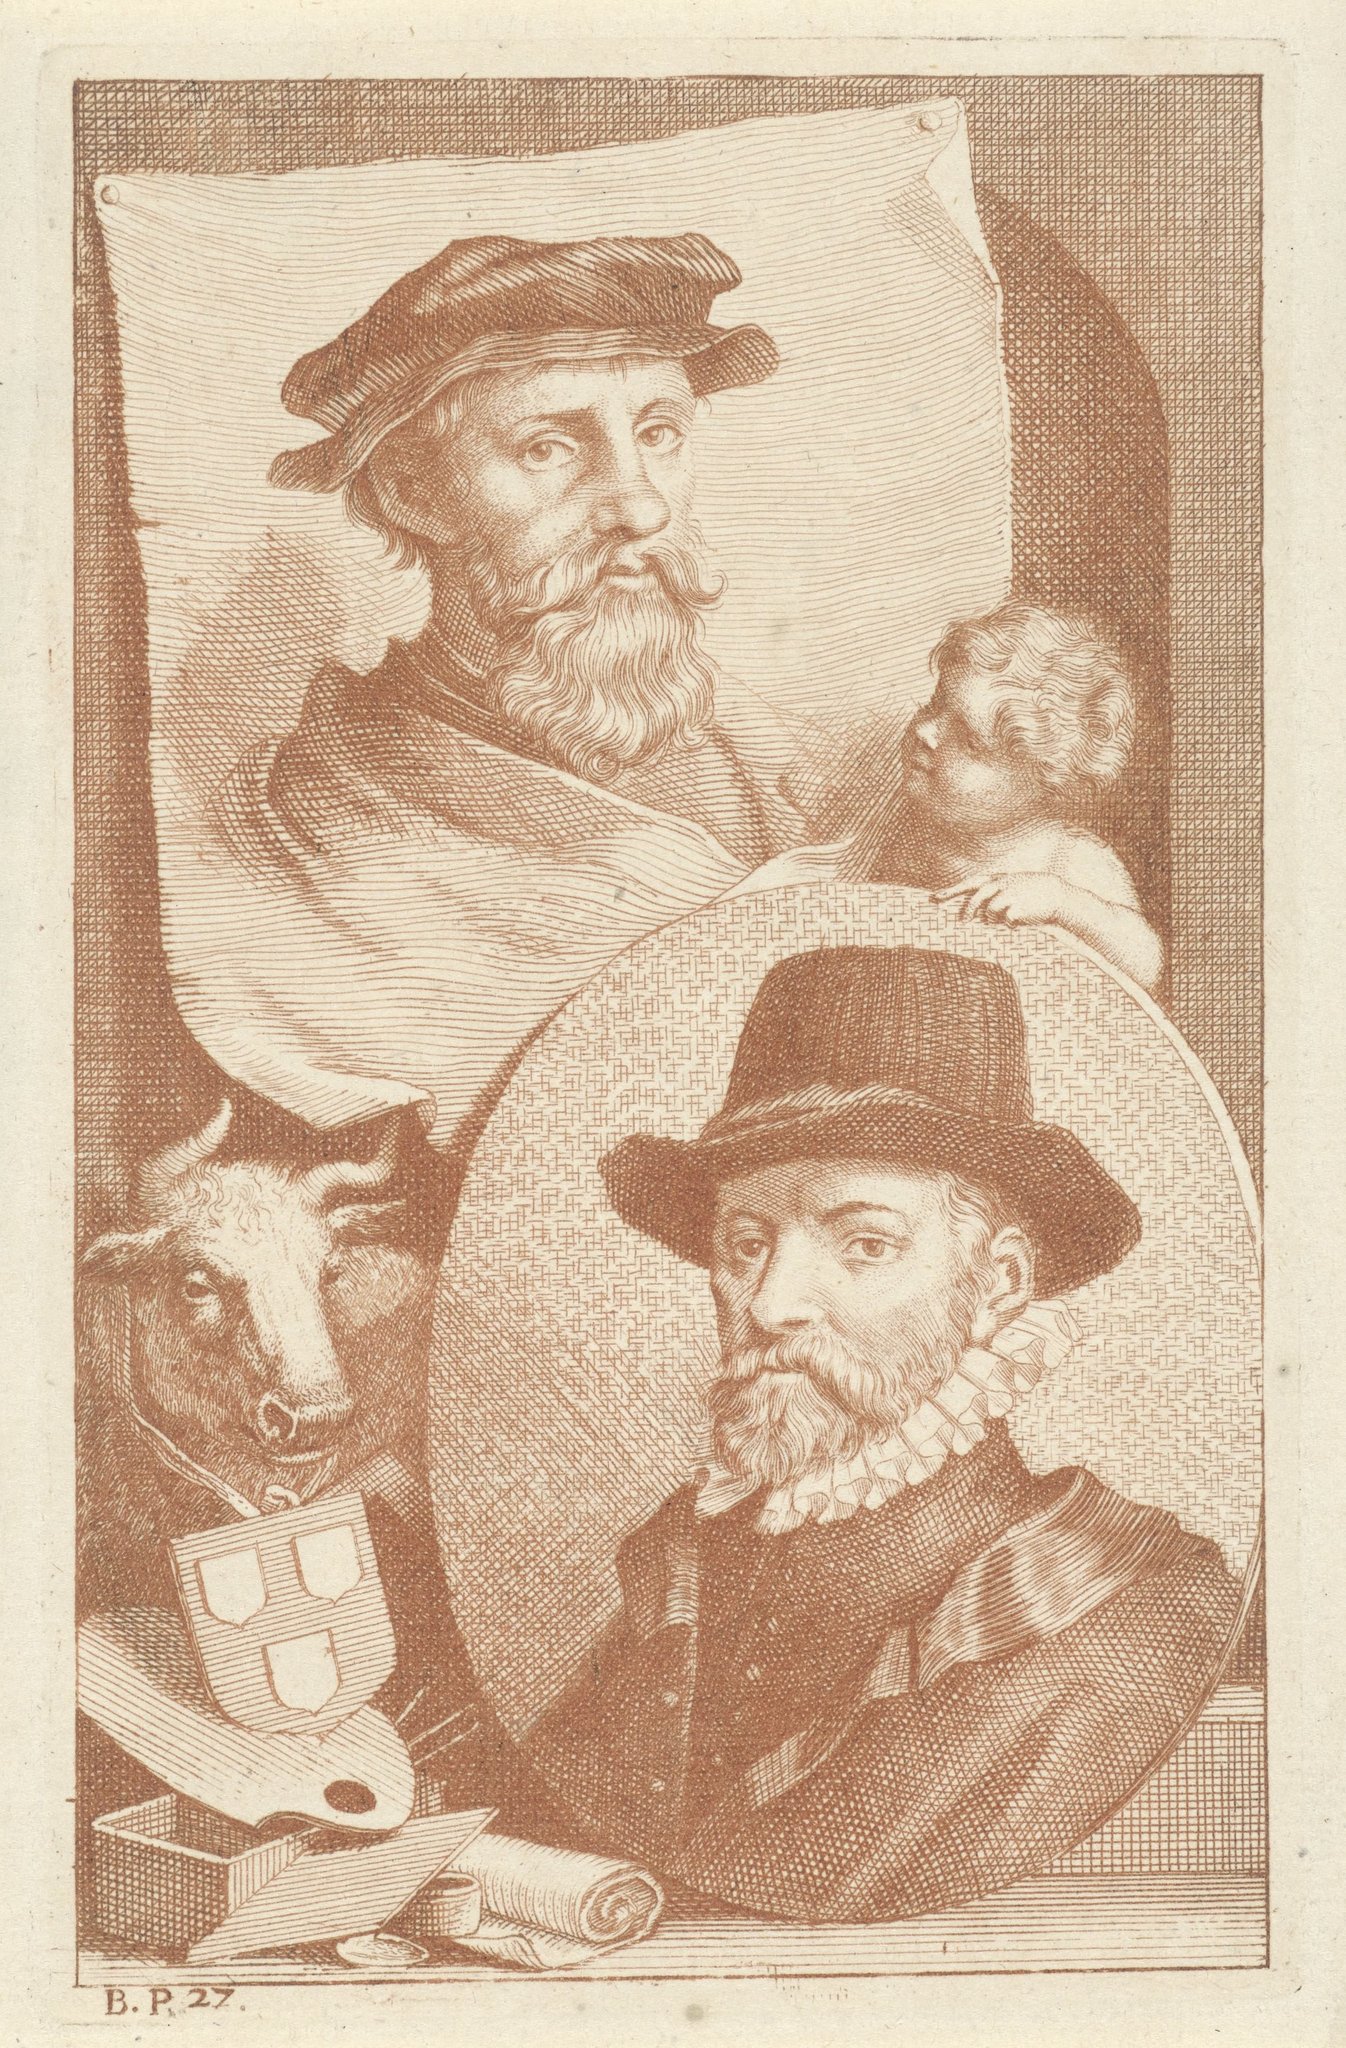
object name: print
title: Portretten van Dirck en Wouter Pietersz. Crabeth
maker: jacob houbraken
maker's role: draughtsman, print maker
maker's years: 1698-1780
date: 1718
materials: paper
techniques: printing, engraving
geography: amsterdam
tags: gouda, draughtsman, dirck pietersz. crabeth, designer, wouter pietersz i crabeth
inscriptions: collector's mark: Lugt 2228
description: Prent ook gebruikt in: Arnold Houbraken. De groote Schouburgh der Nederlantsche konstschilders en schilderessen : waar van 'er vele met hunne beeltenissen ten tooneel verschynen, ... zynde een vervolg op het Schilderboek van K. van Mander. 3 dln. Eerste druk. Amsterdam: 1718-1721.